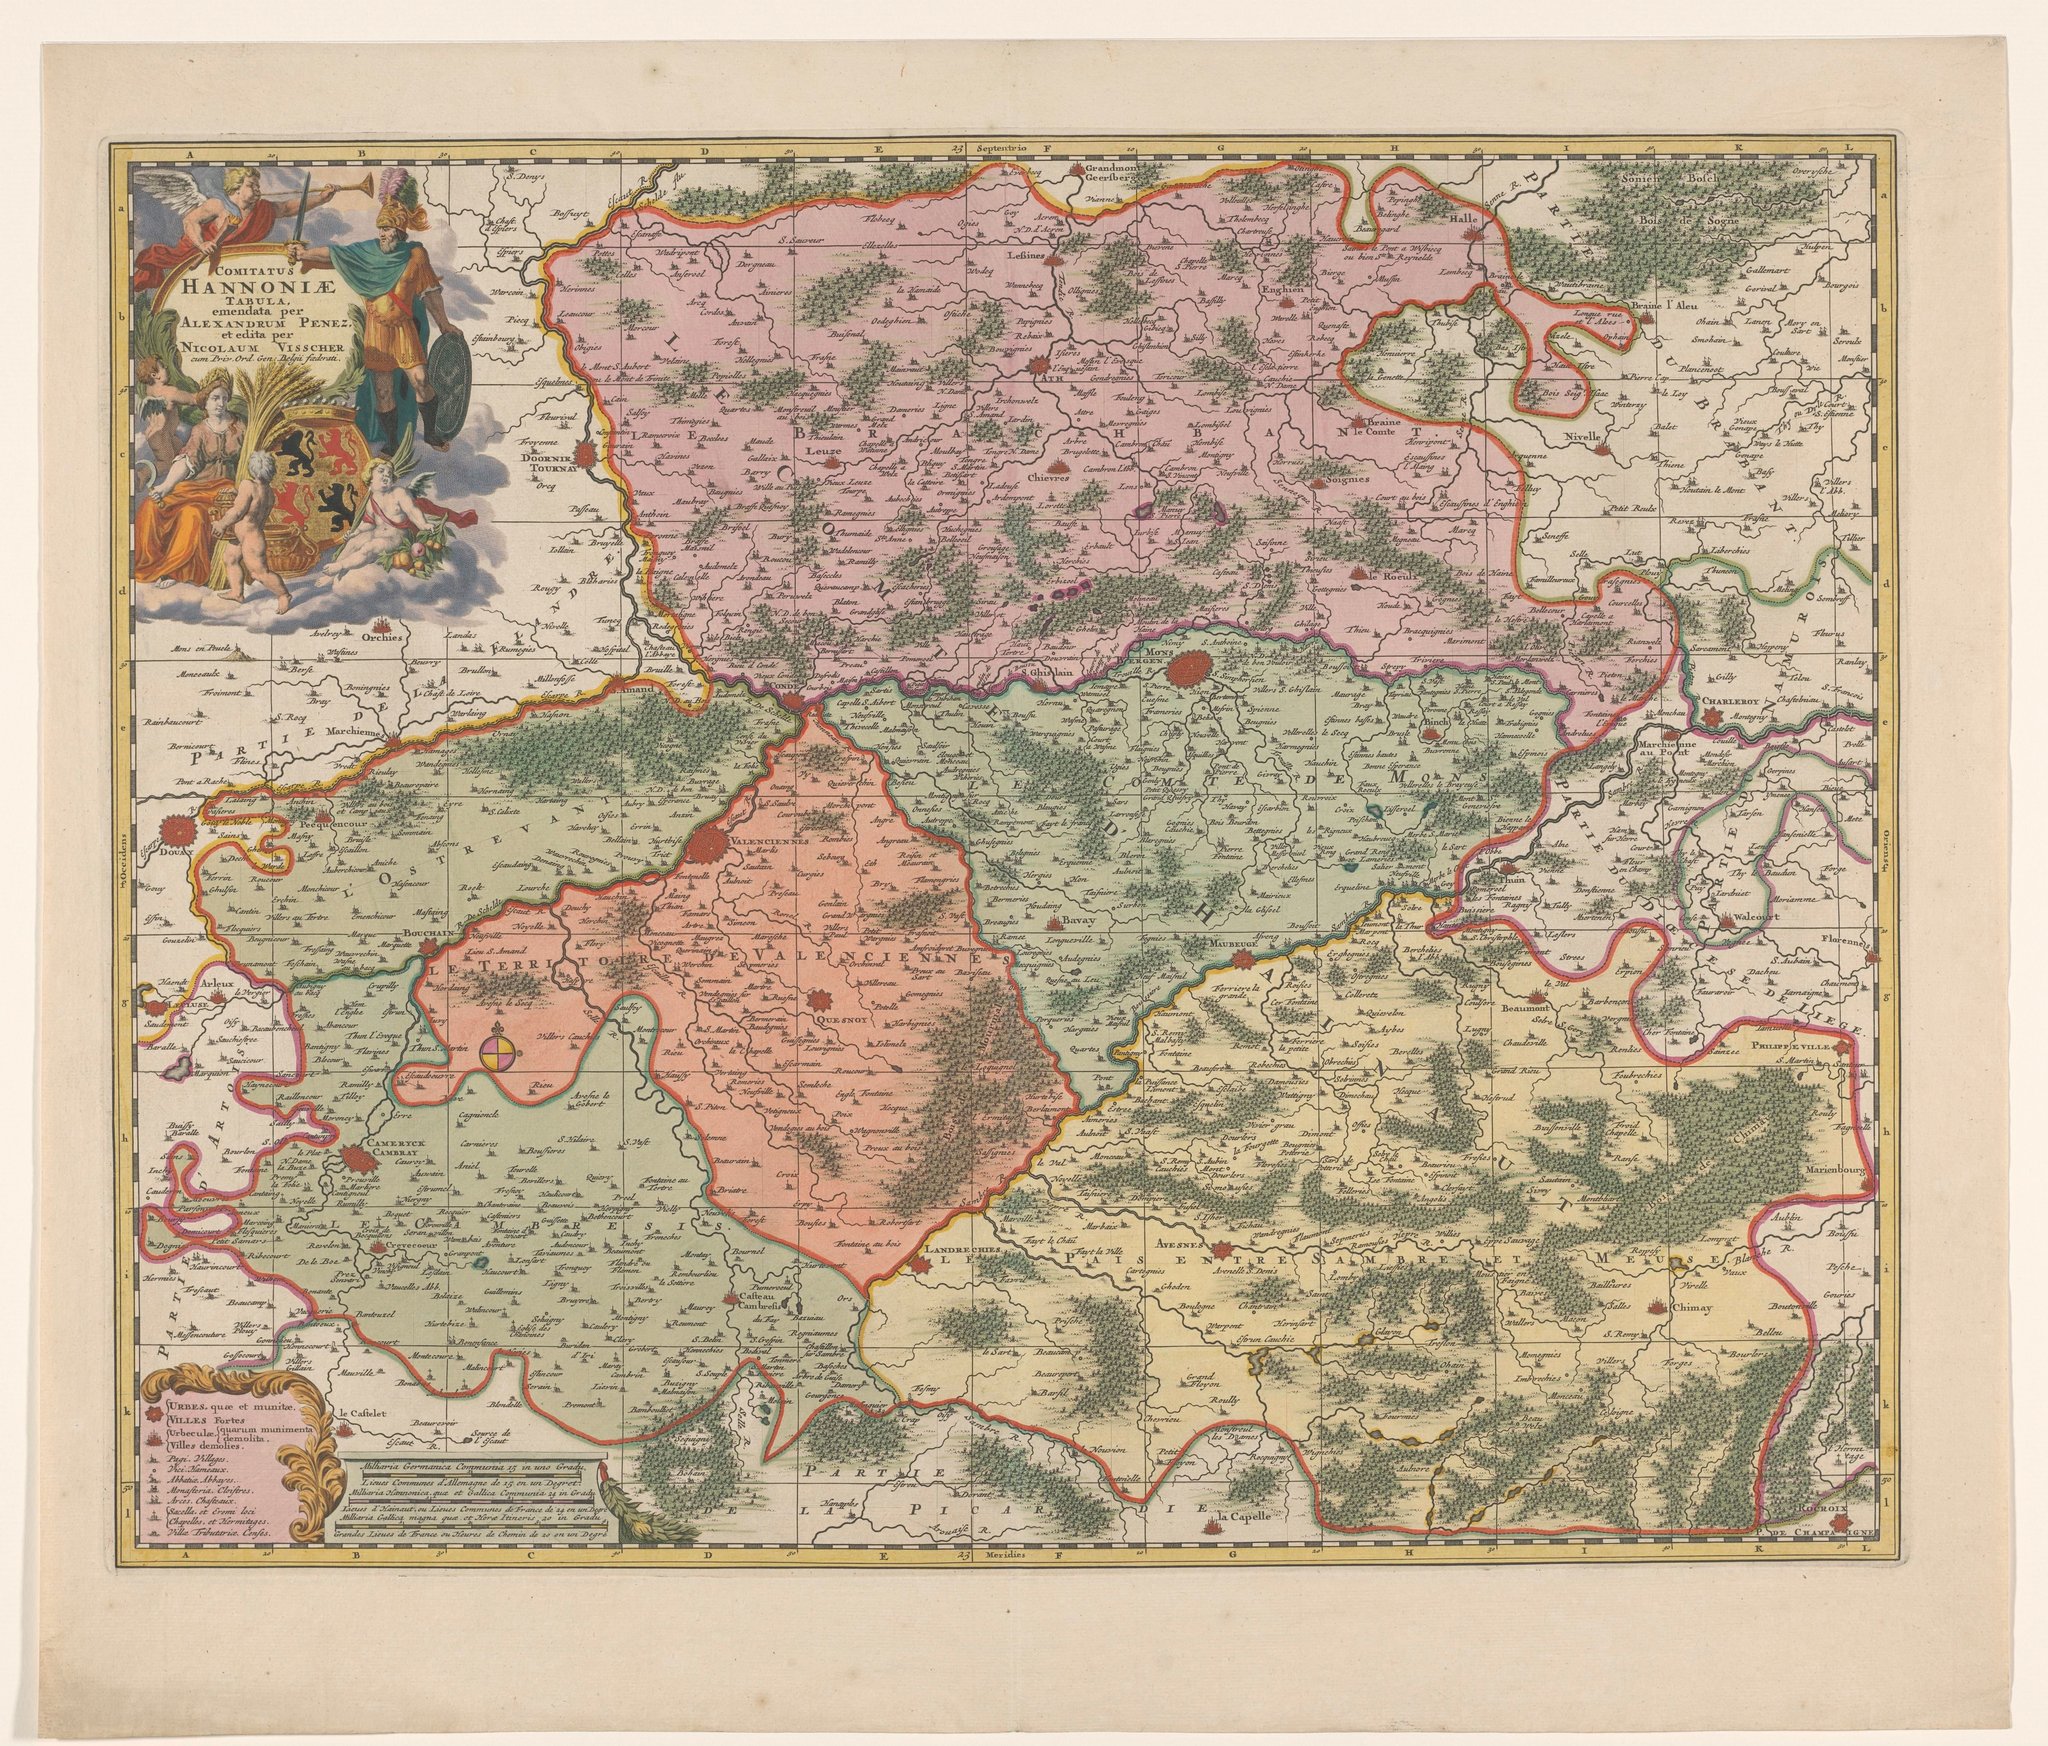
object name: print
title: Comitatus Hannoniae tabula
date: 1677-1720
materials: paper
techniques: engraving, etching, hand coloring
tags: maps of separate countries or regions, coat of arms (as symbol of the state, etc.) (+ province; provincial), henegouwen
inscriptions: collector's mark: Lugt 2228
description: Kaart van Henegouwen. Linksboven de titelcartouche met het wapen van Henegouwen. Linksonder een cartouche met legenda. Links daarvan drie schaalstokken: 2 Lieues Communes d'Allemagne de 15 en un Degret / 3 Lieues d'Hainaut, ou Lieues Communes de France de 24 en un Degré / 4 Grandes Lieues de France ou Heures de Chemin de 20 en un Degré. De kaart is voorzien van een zoekrooster en een gradenverdeling langs de randen.